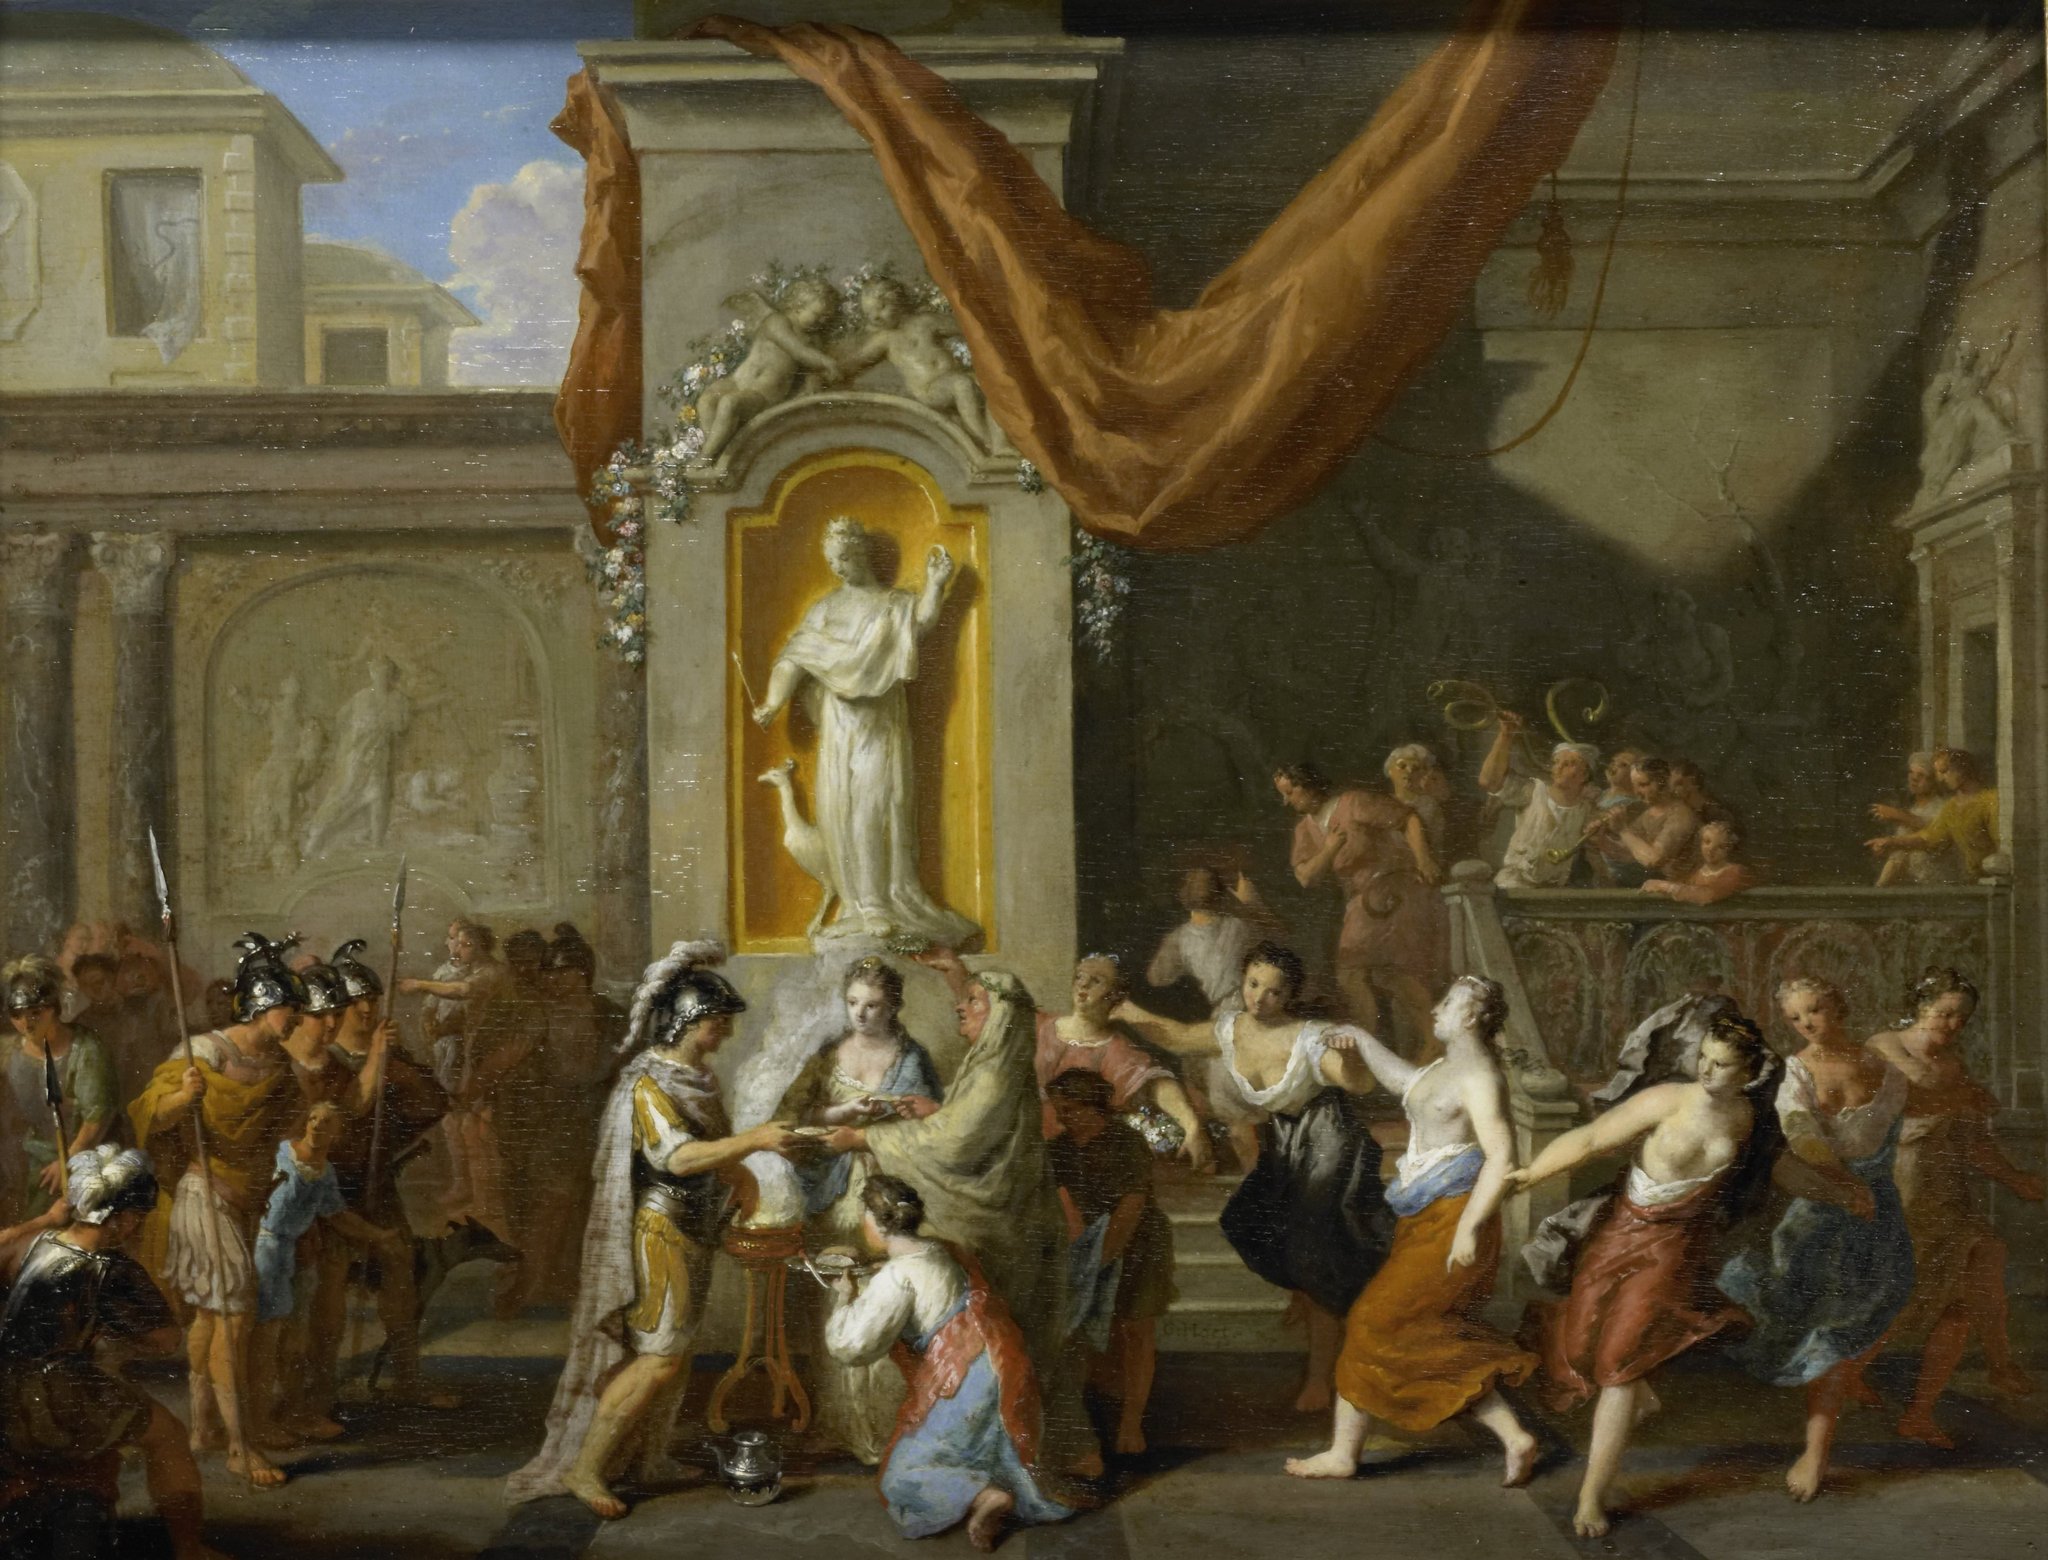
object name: painting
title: The Marriage of Alexander the Great and Roxane of Bactria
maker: gerard hoet (i)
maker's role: draughtsman, painter, print maker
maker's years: 1648-1733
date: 1670-1733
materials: oil, panel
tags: marriage of alexander and roxana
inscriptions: signature: ‘G: Hoet.’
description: Het huwelijk van Alexander de Grote met Roxane van Bactrië. Het huwelijk wordt links op de voorgrond ingezegend door een priester bij een brandend altaar, voor een nis met een standbeeld van Juno. Links de soldaten uit het gevolg van Alexander. Rechts een groep dansende vrouwen, rechtsachter staan muzikanten op een balkon. Pendant van SK-A-162.